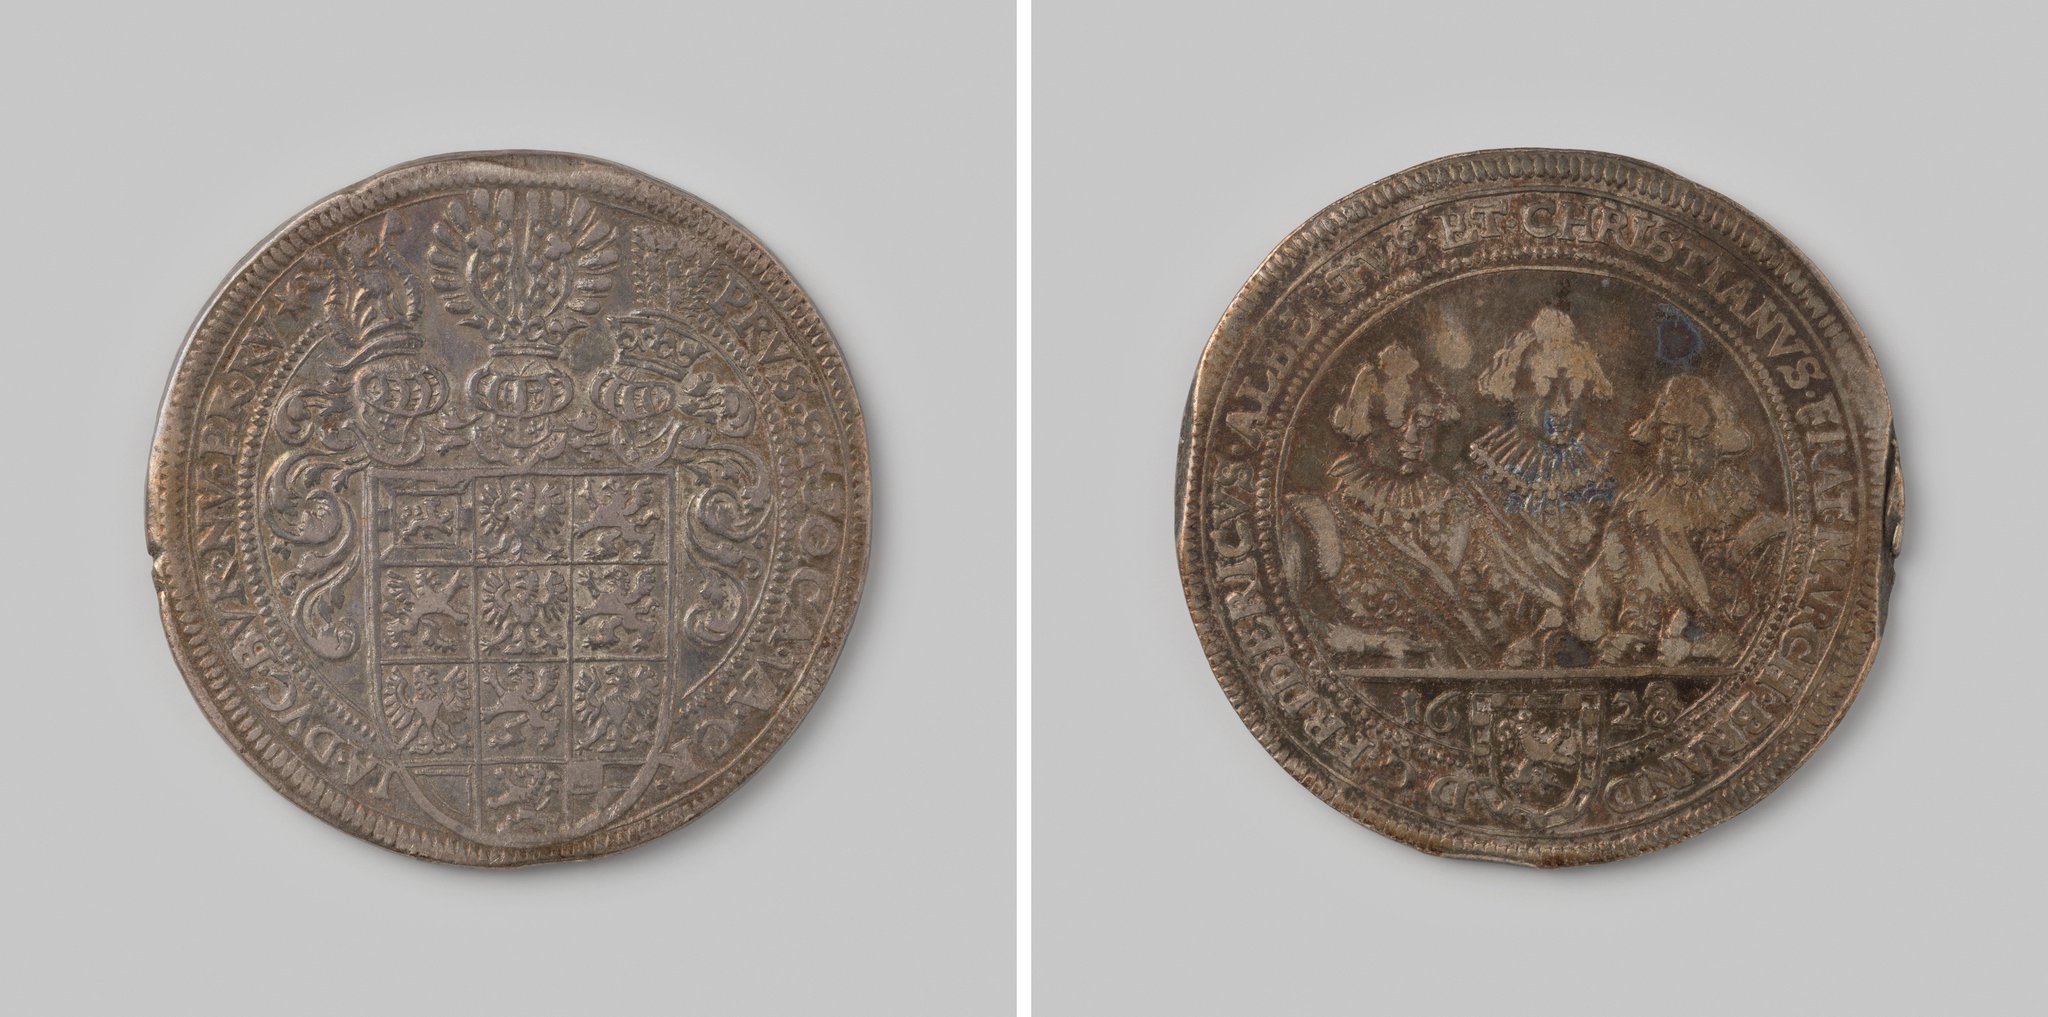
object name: coin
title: Markgraafschap Brandenburg-Ansbach, taler, 1628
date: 1628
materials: silver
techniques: striking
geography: nuremberg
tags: regent, sophie van solms-laubach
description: Zilveren munt. Voorzijde: samengesteld wapenschild, waarop drie helmtekens. Keerzijde: portretten van de markgraaf en zijn twee broers. In afsnede tussen jaartal wapenschild.